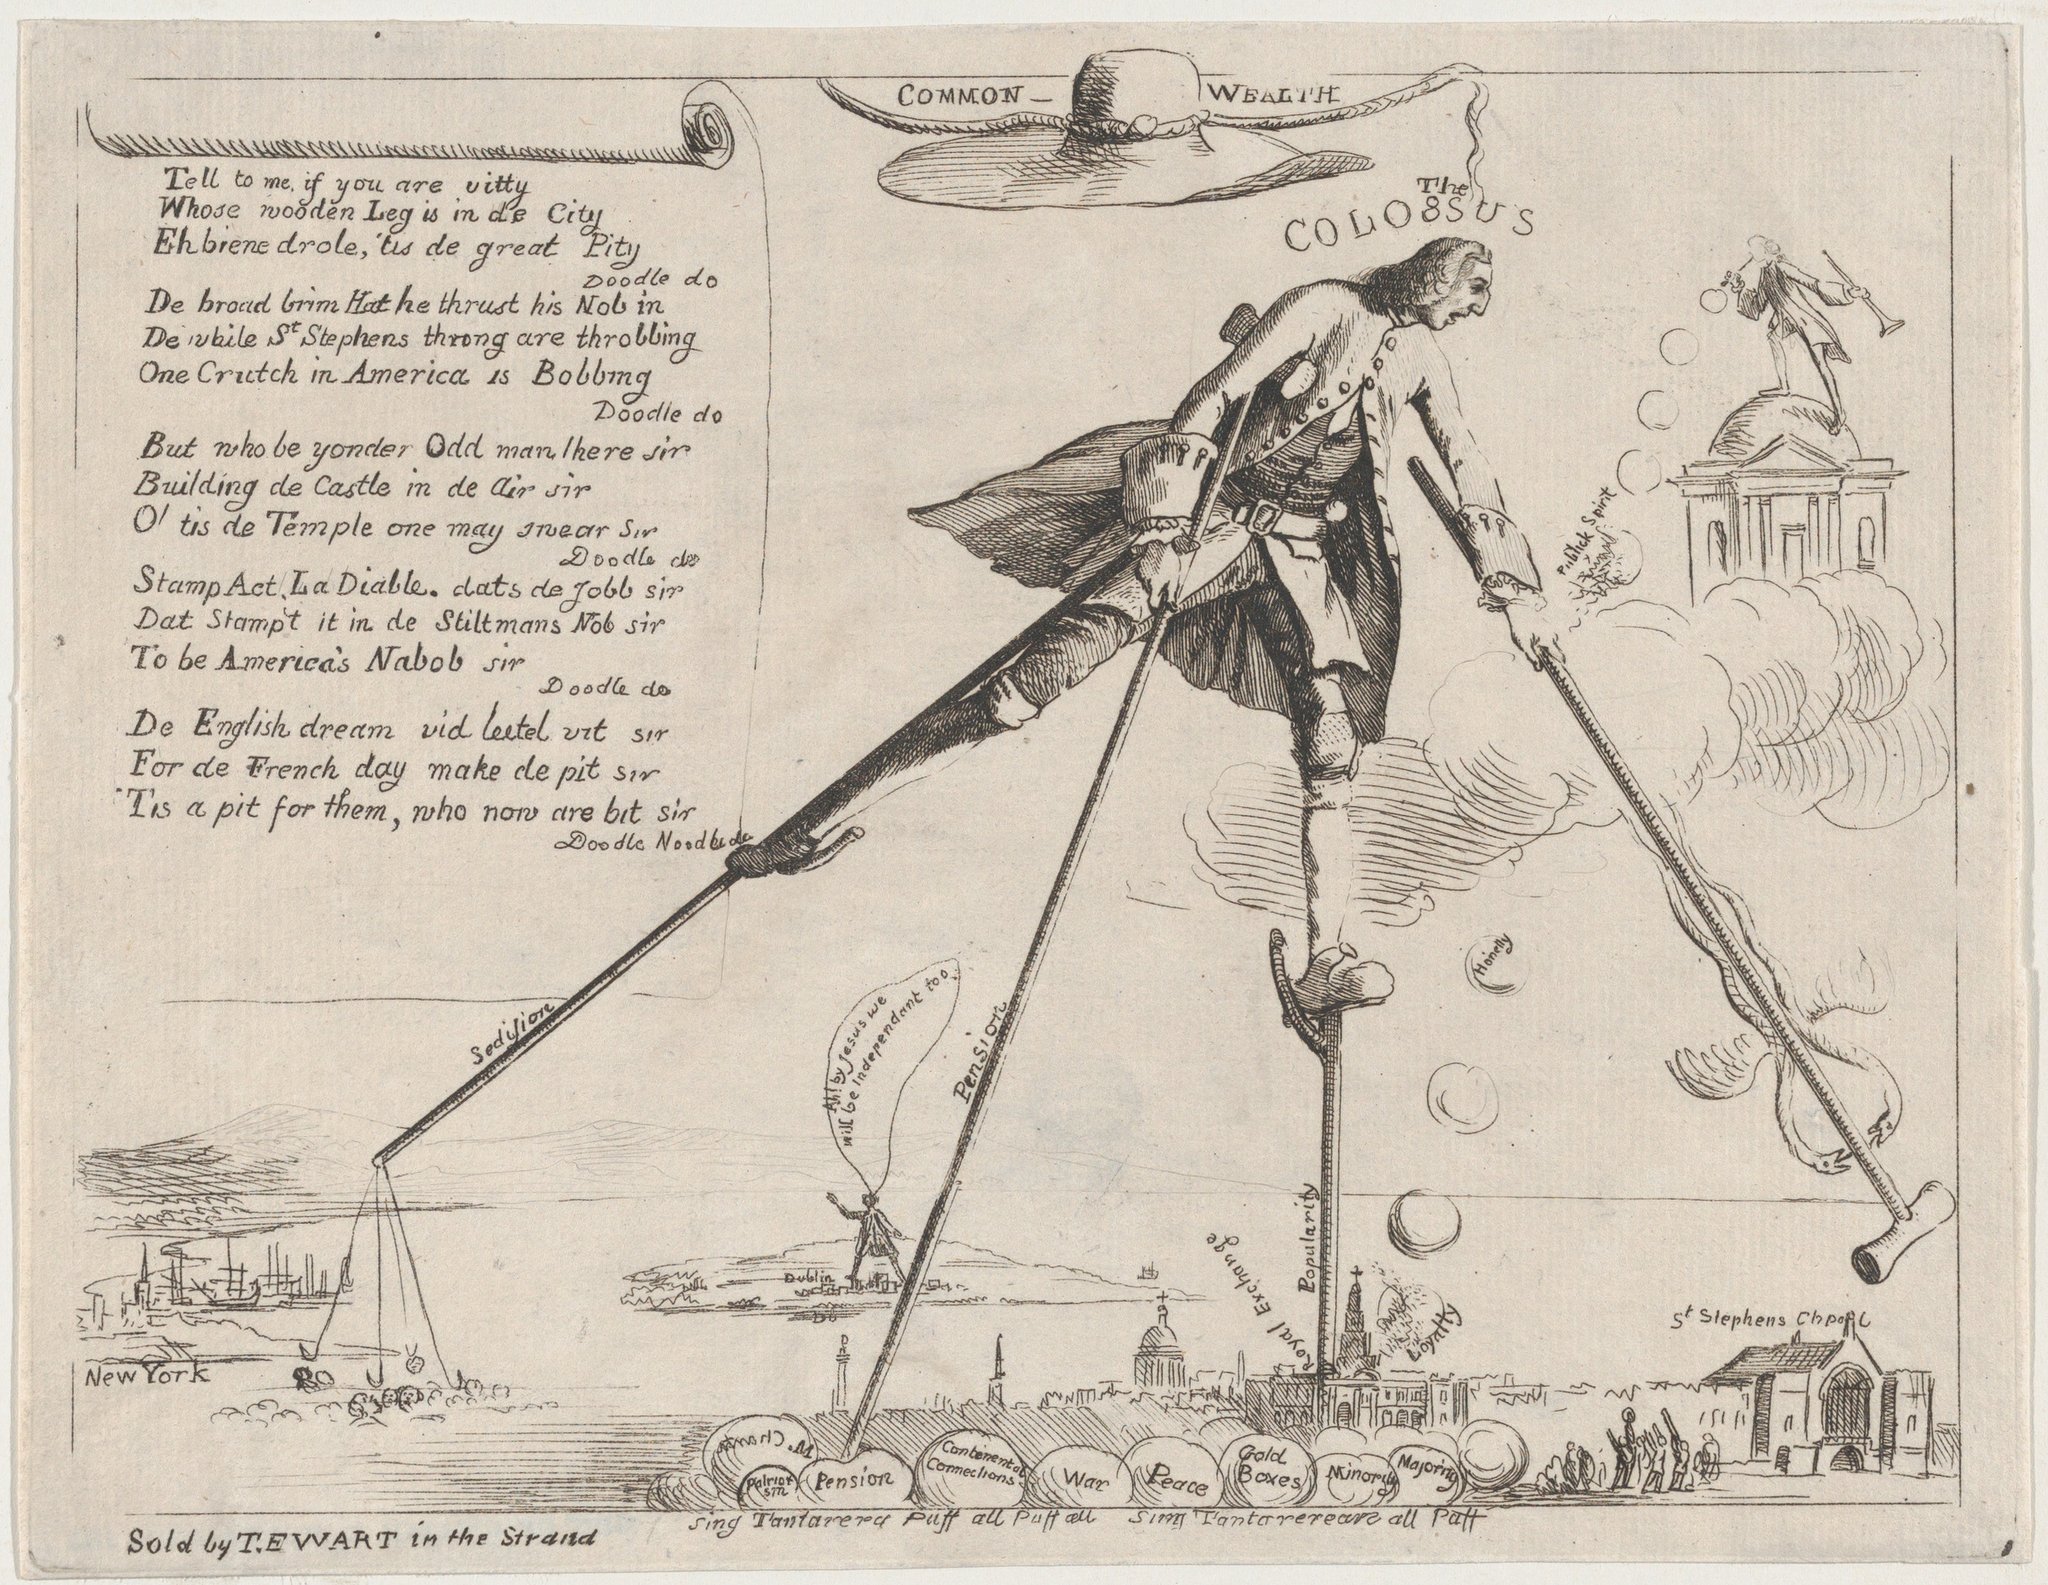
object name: print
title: Common-Wealth, The Colossus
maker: anonymous, british, 18th century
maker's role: artist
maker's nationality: british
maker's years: 1700-1800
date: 1766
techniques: etching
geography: london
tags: american revolution,men,caricature,politics